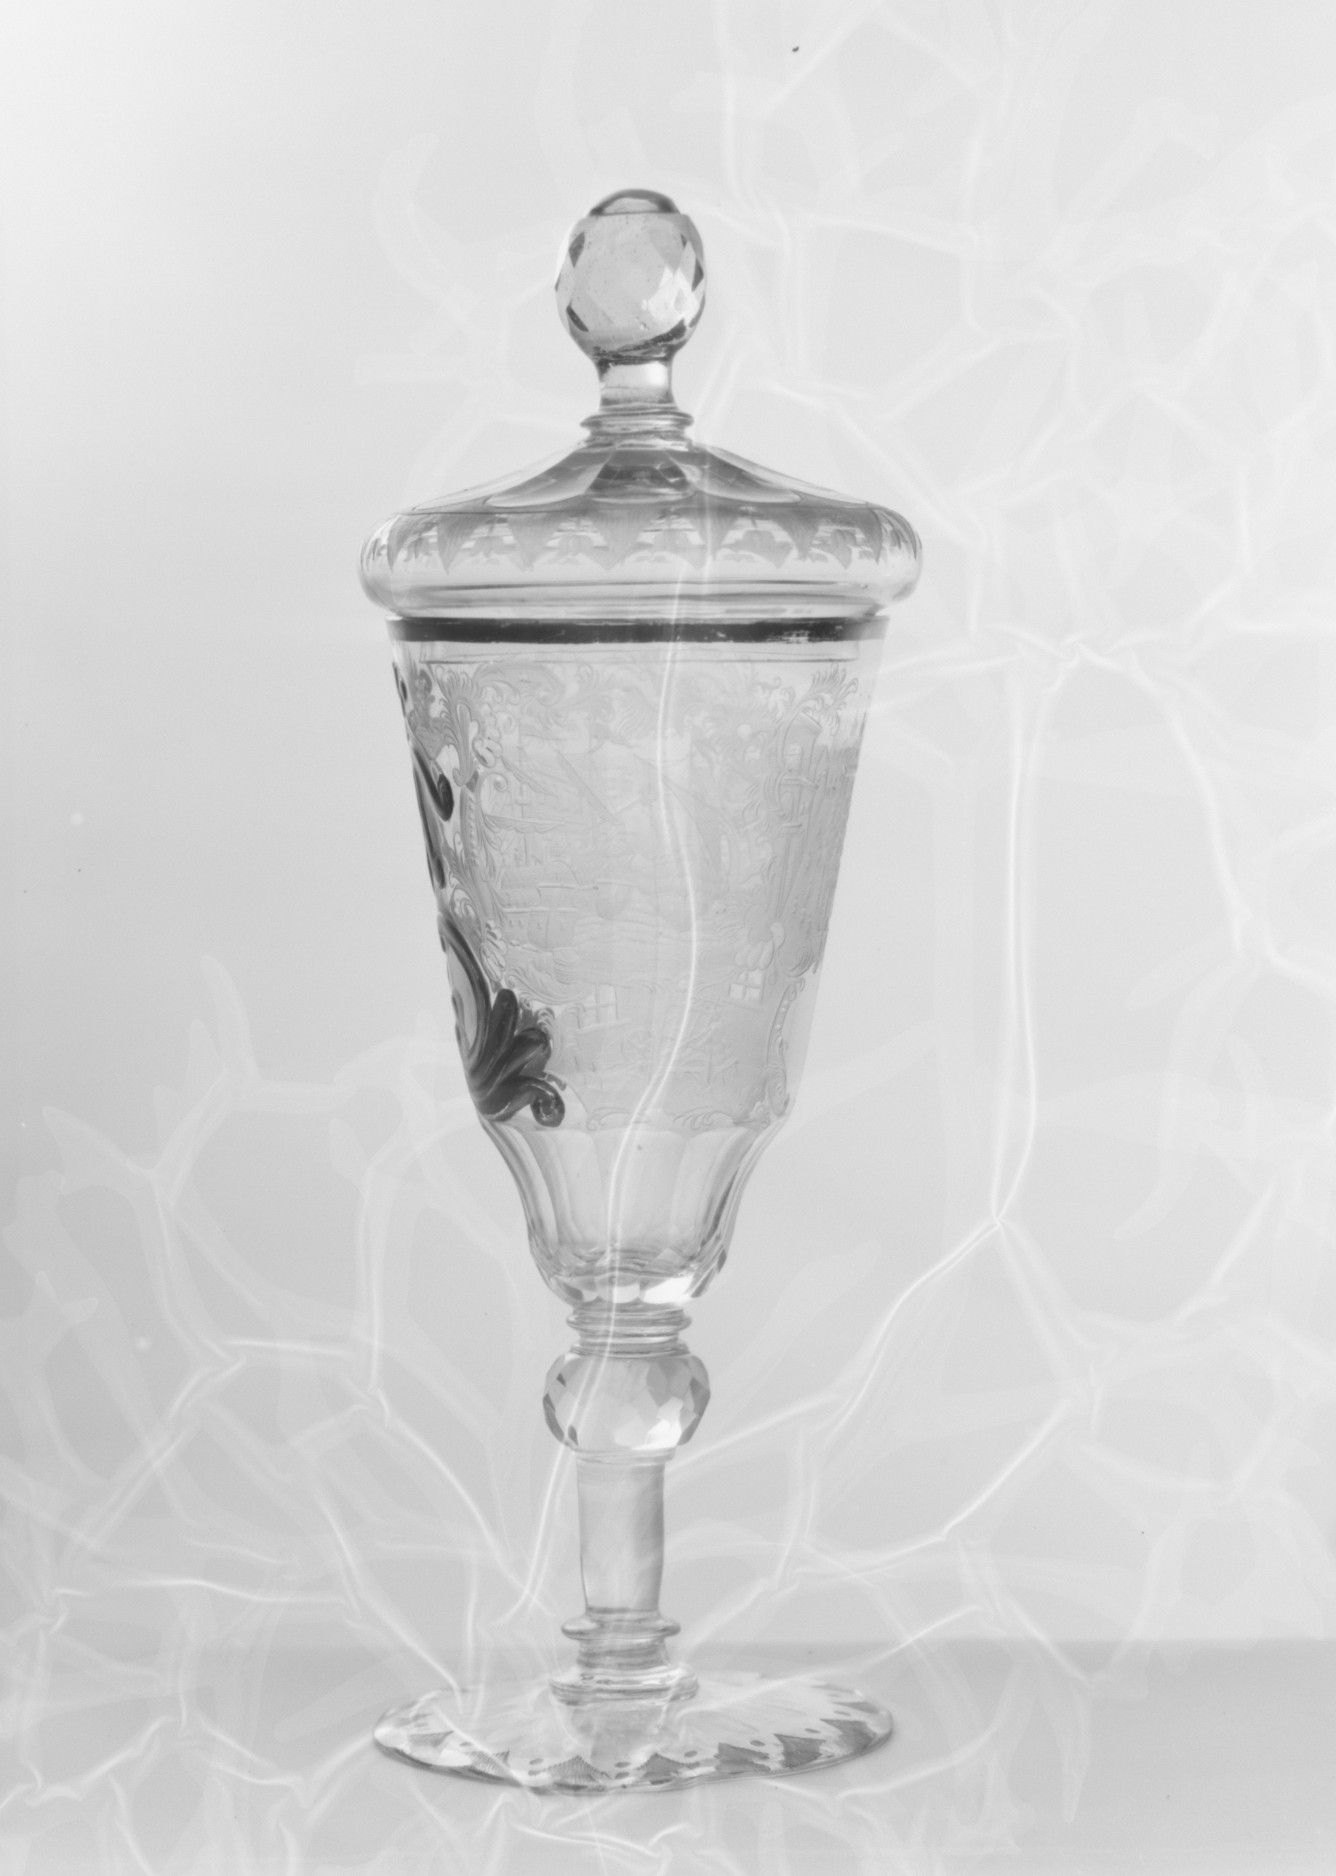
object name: standing cup with cover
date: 1760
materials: glass